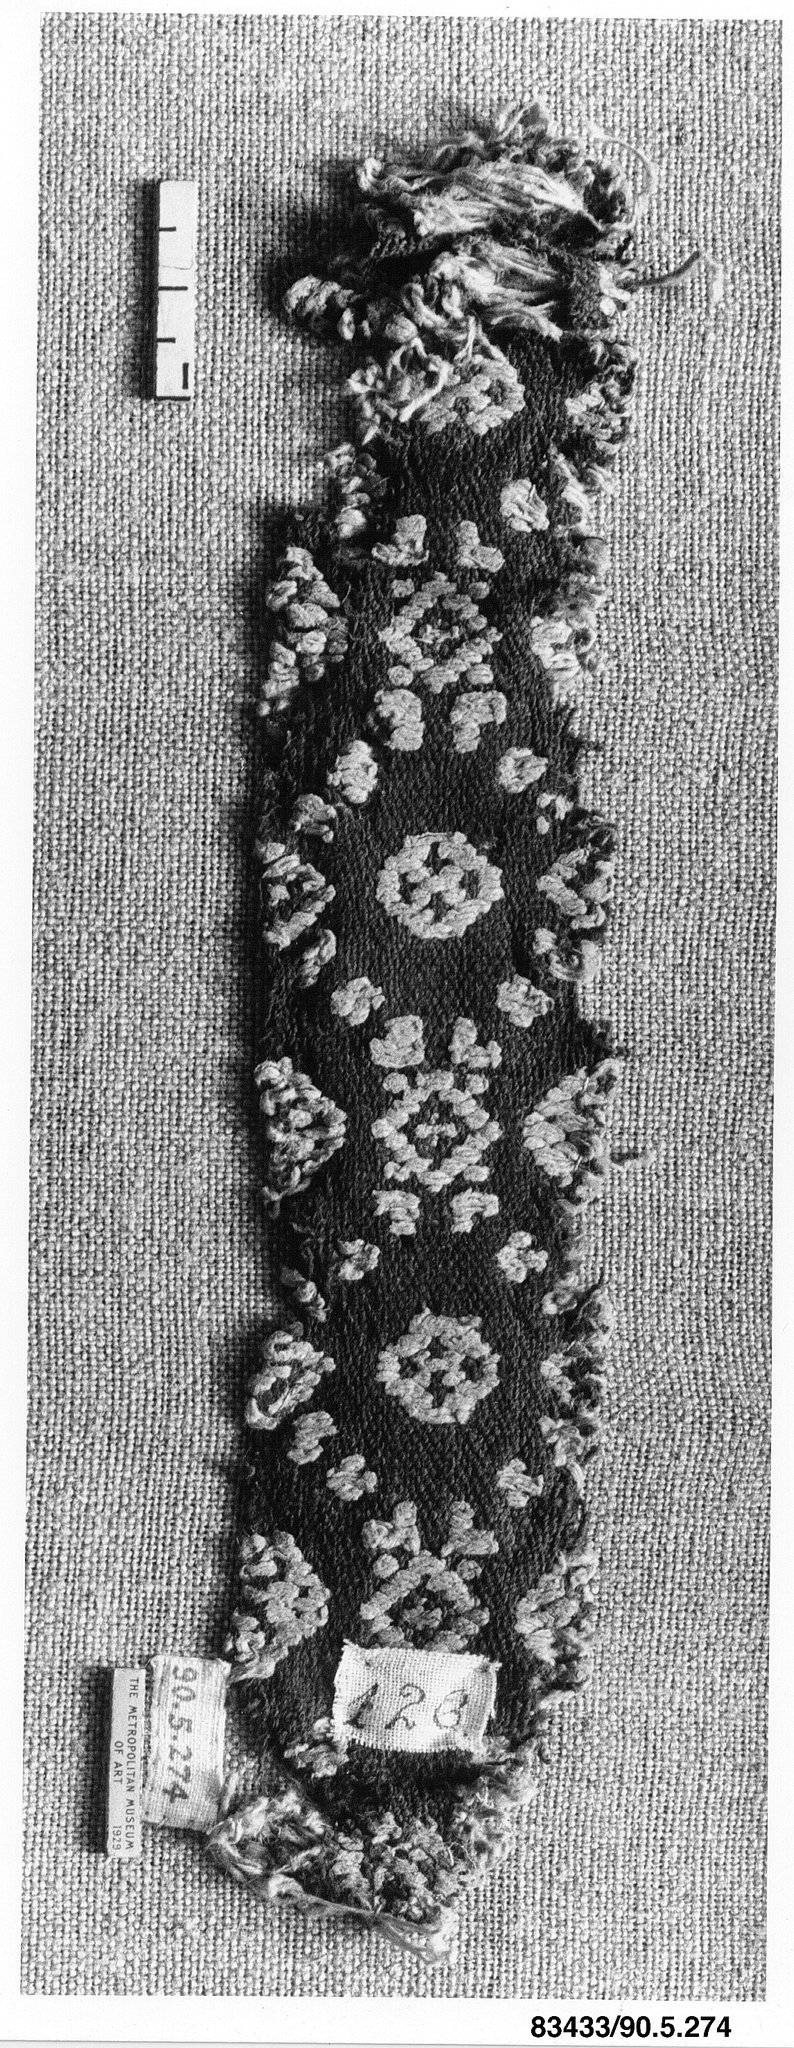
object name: textile fragment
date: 401-600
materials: linen, wool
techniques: weave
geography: egypt